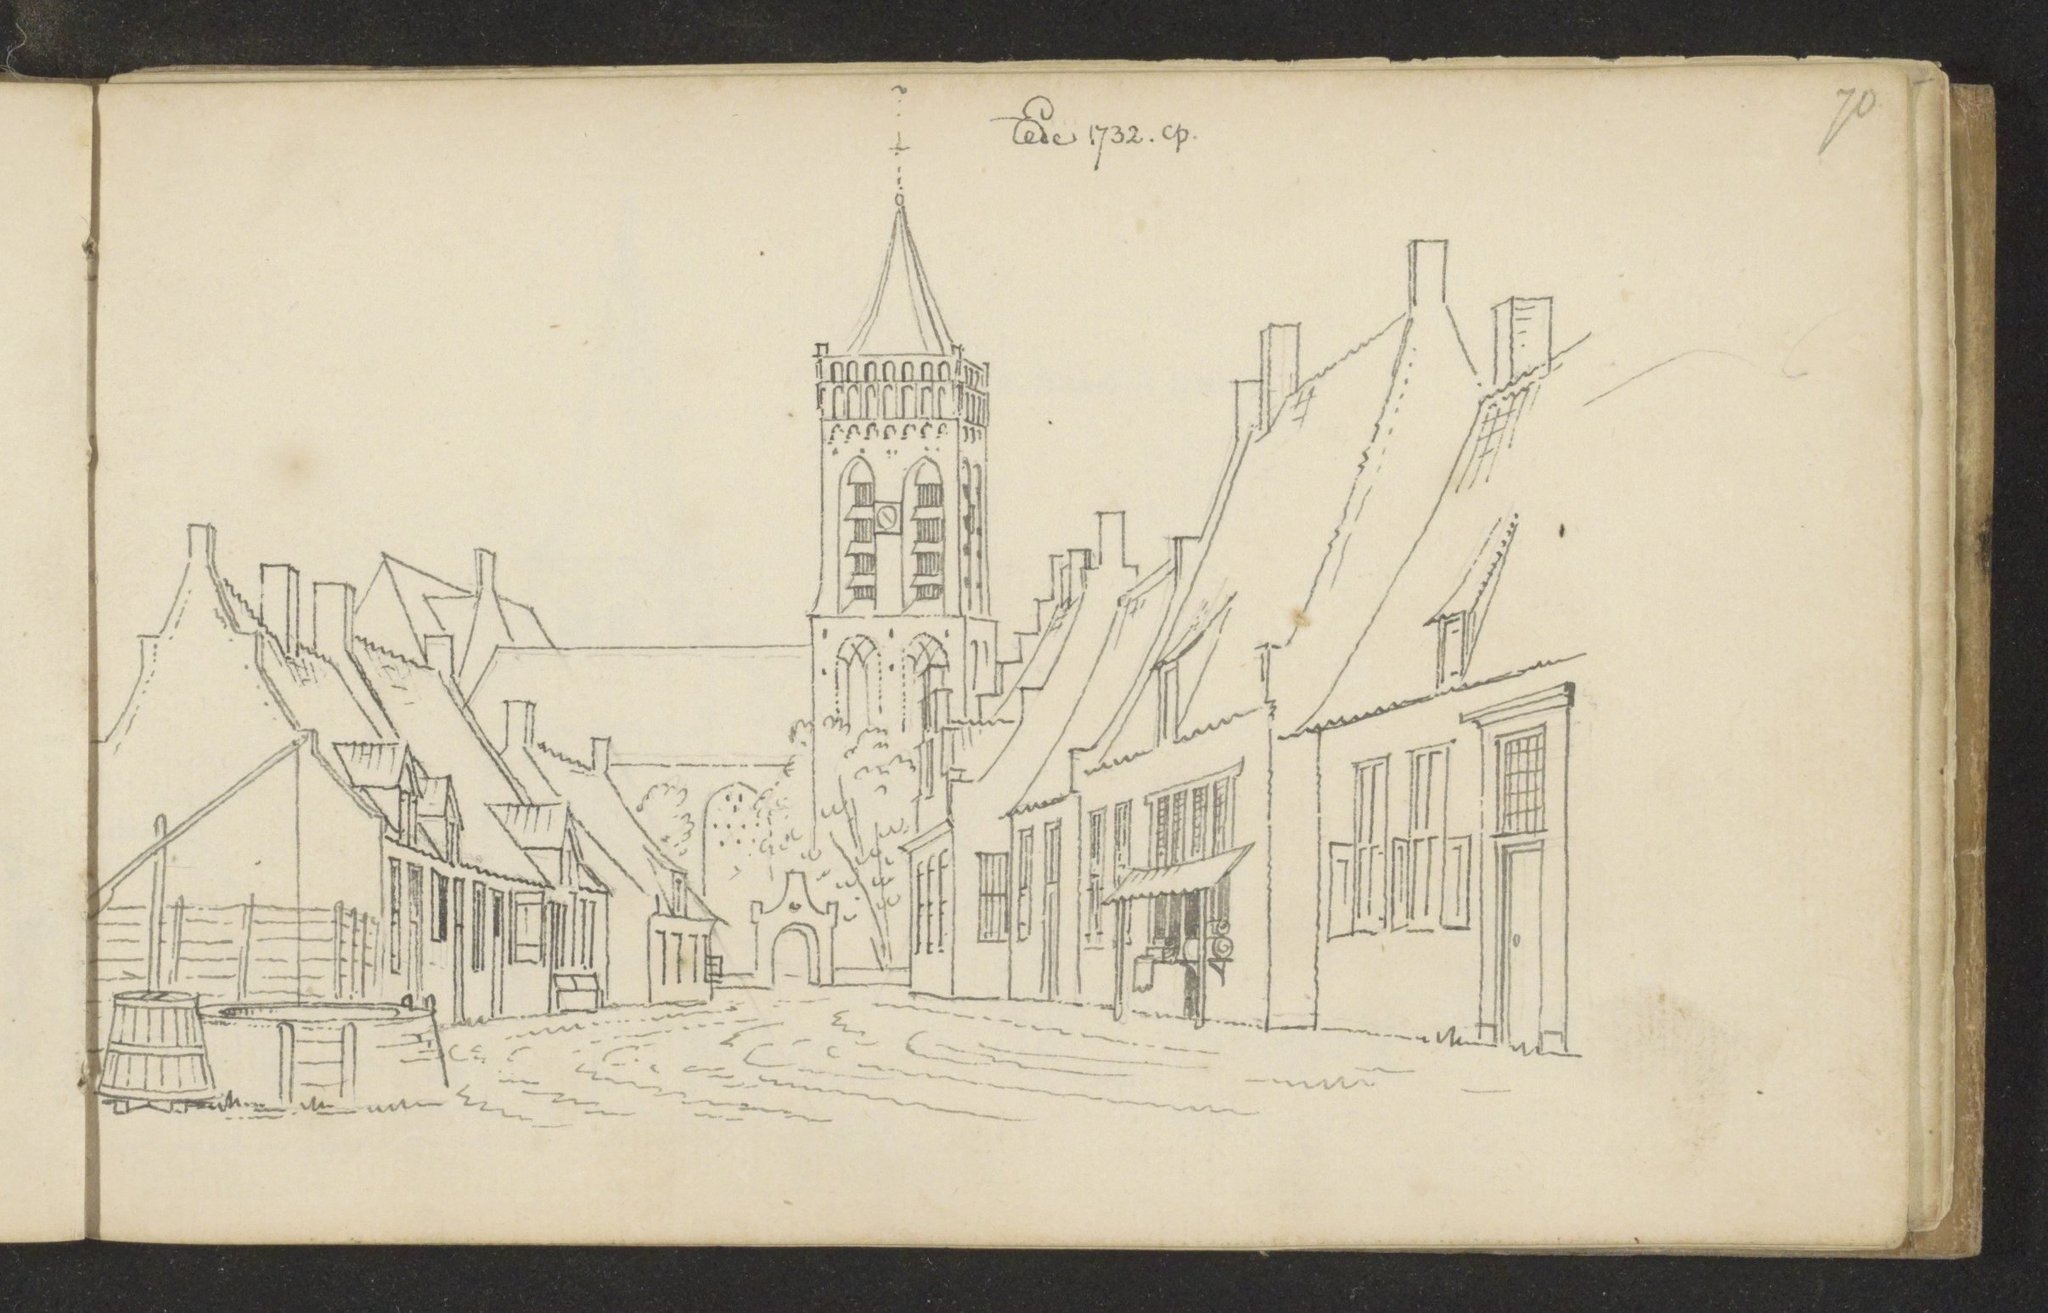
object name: sketchbook leaf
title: Dorpsgezicht te Ede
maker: abraham de haen (ii)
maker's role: draughtsman, print maker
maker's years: 1707-1748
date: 1731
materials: ink, paper, pencil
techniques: pen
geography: ede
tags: village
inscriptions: date and inscription: ‘Eede 1732.cp.’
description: Blad 70 recto uit een schetsboek met 78 bladen.